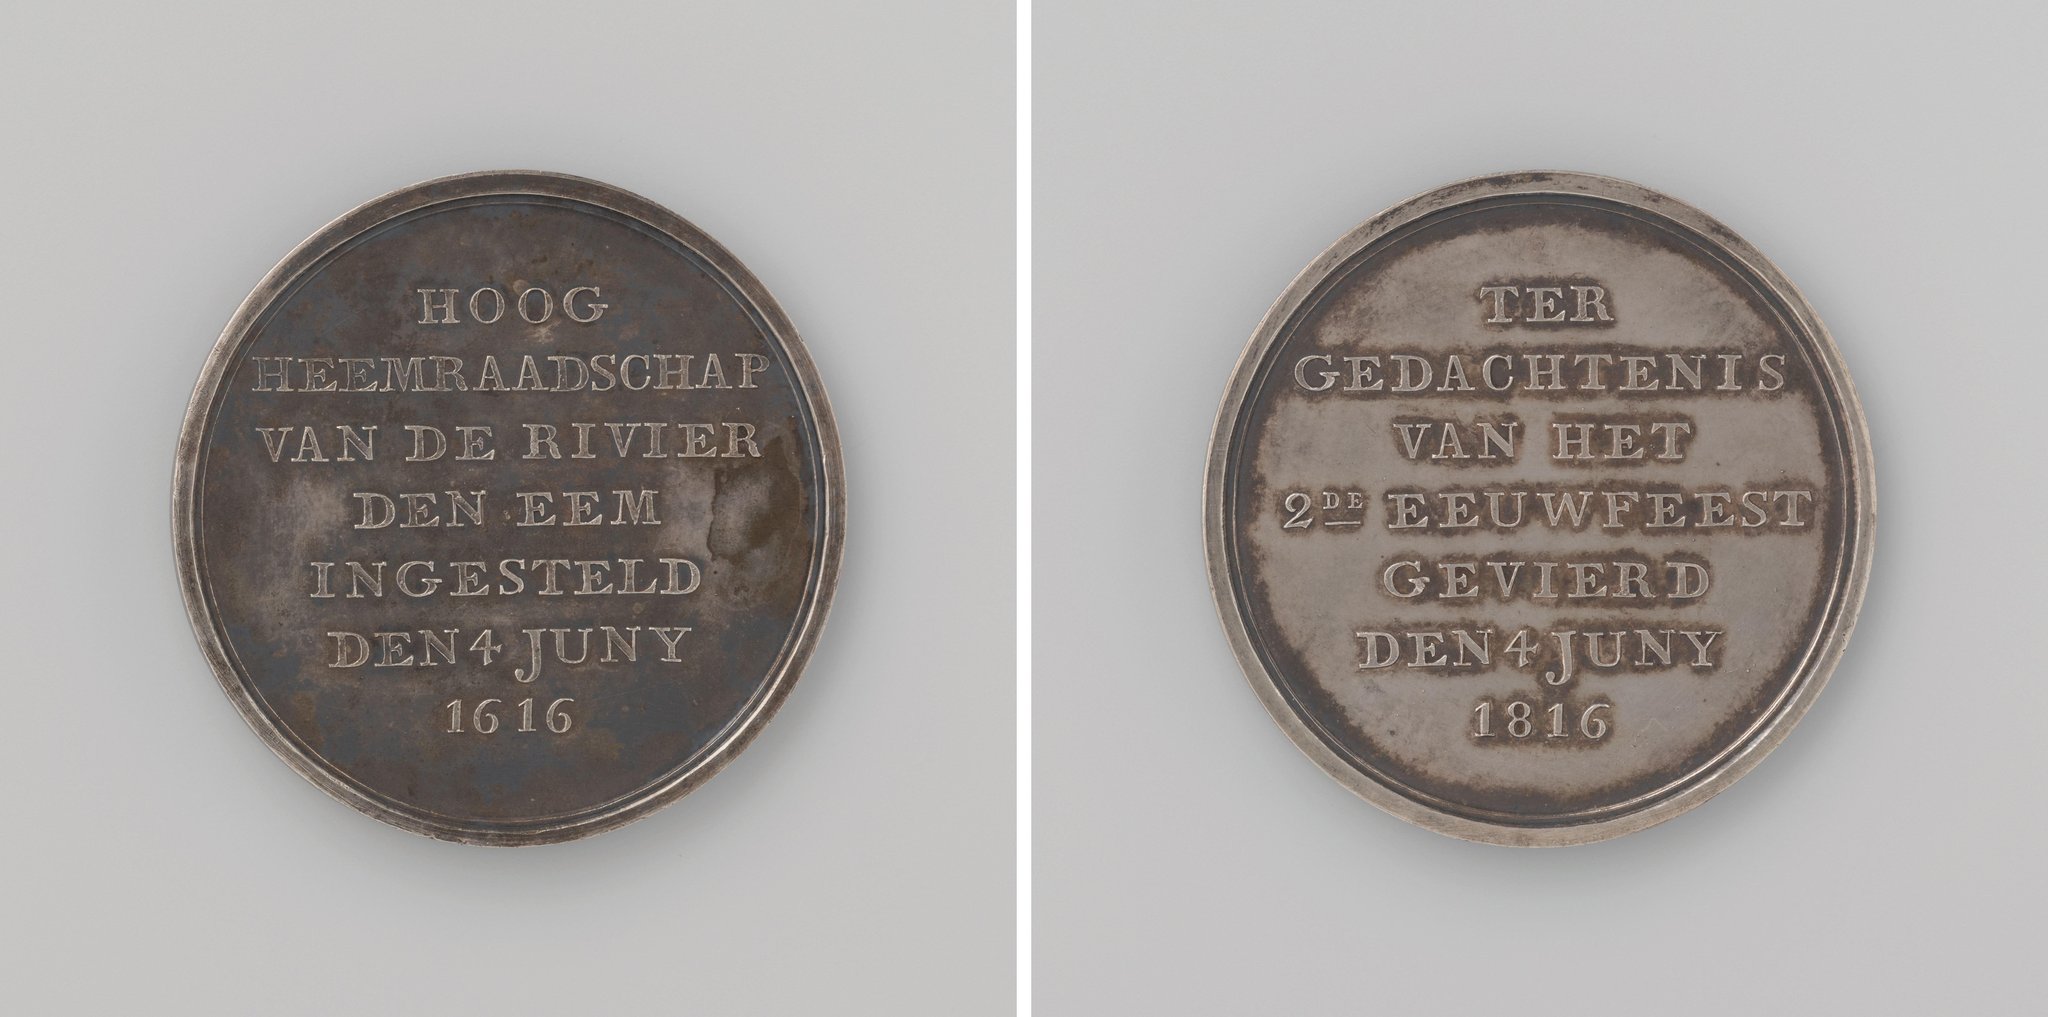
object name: history medal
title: Tweede eeuwfeest van de instelling van het hoogheemraadschap van de rivier de Eem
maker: Anonymous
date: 1816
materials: silver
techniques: striking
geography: netherlands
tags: eem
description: Zilveren penning. Voorzijde: opschrift. Keerzijde: opschrift